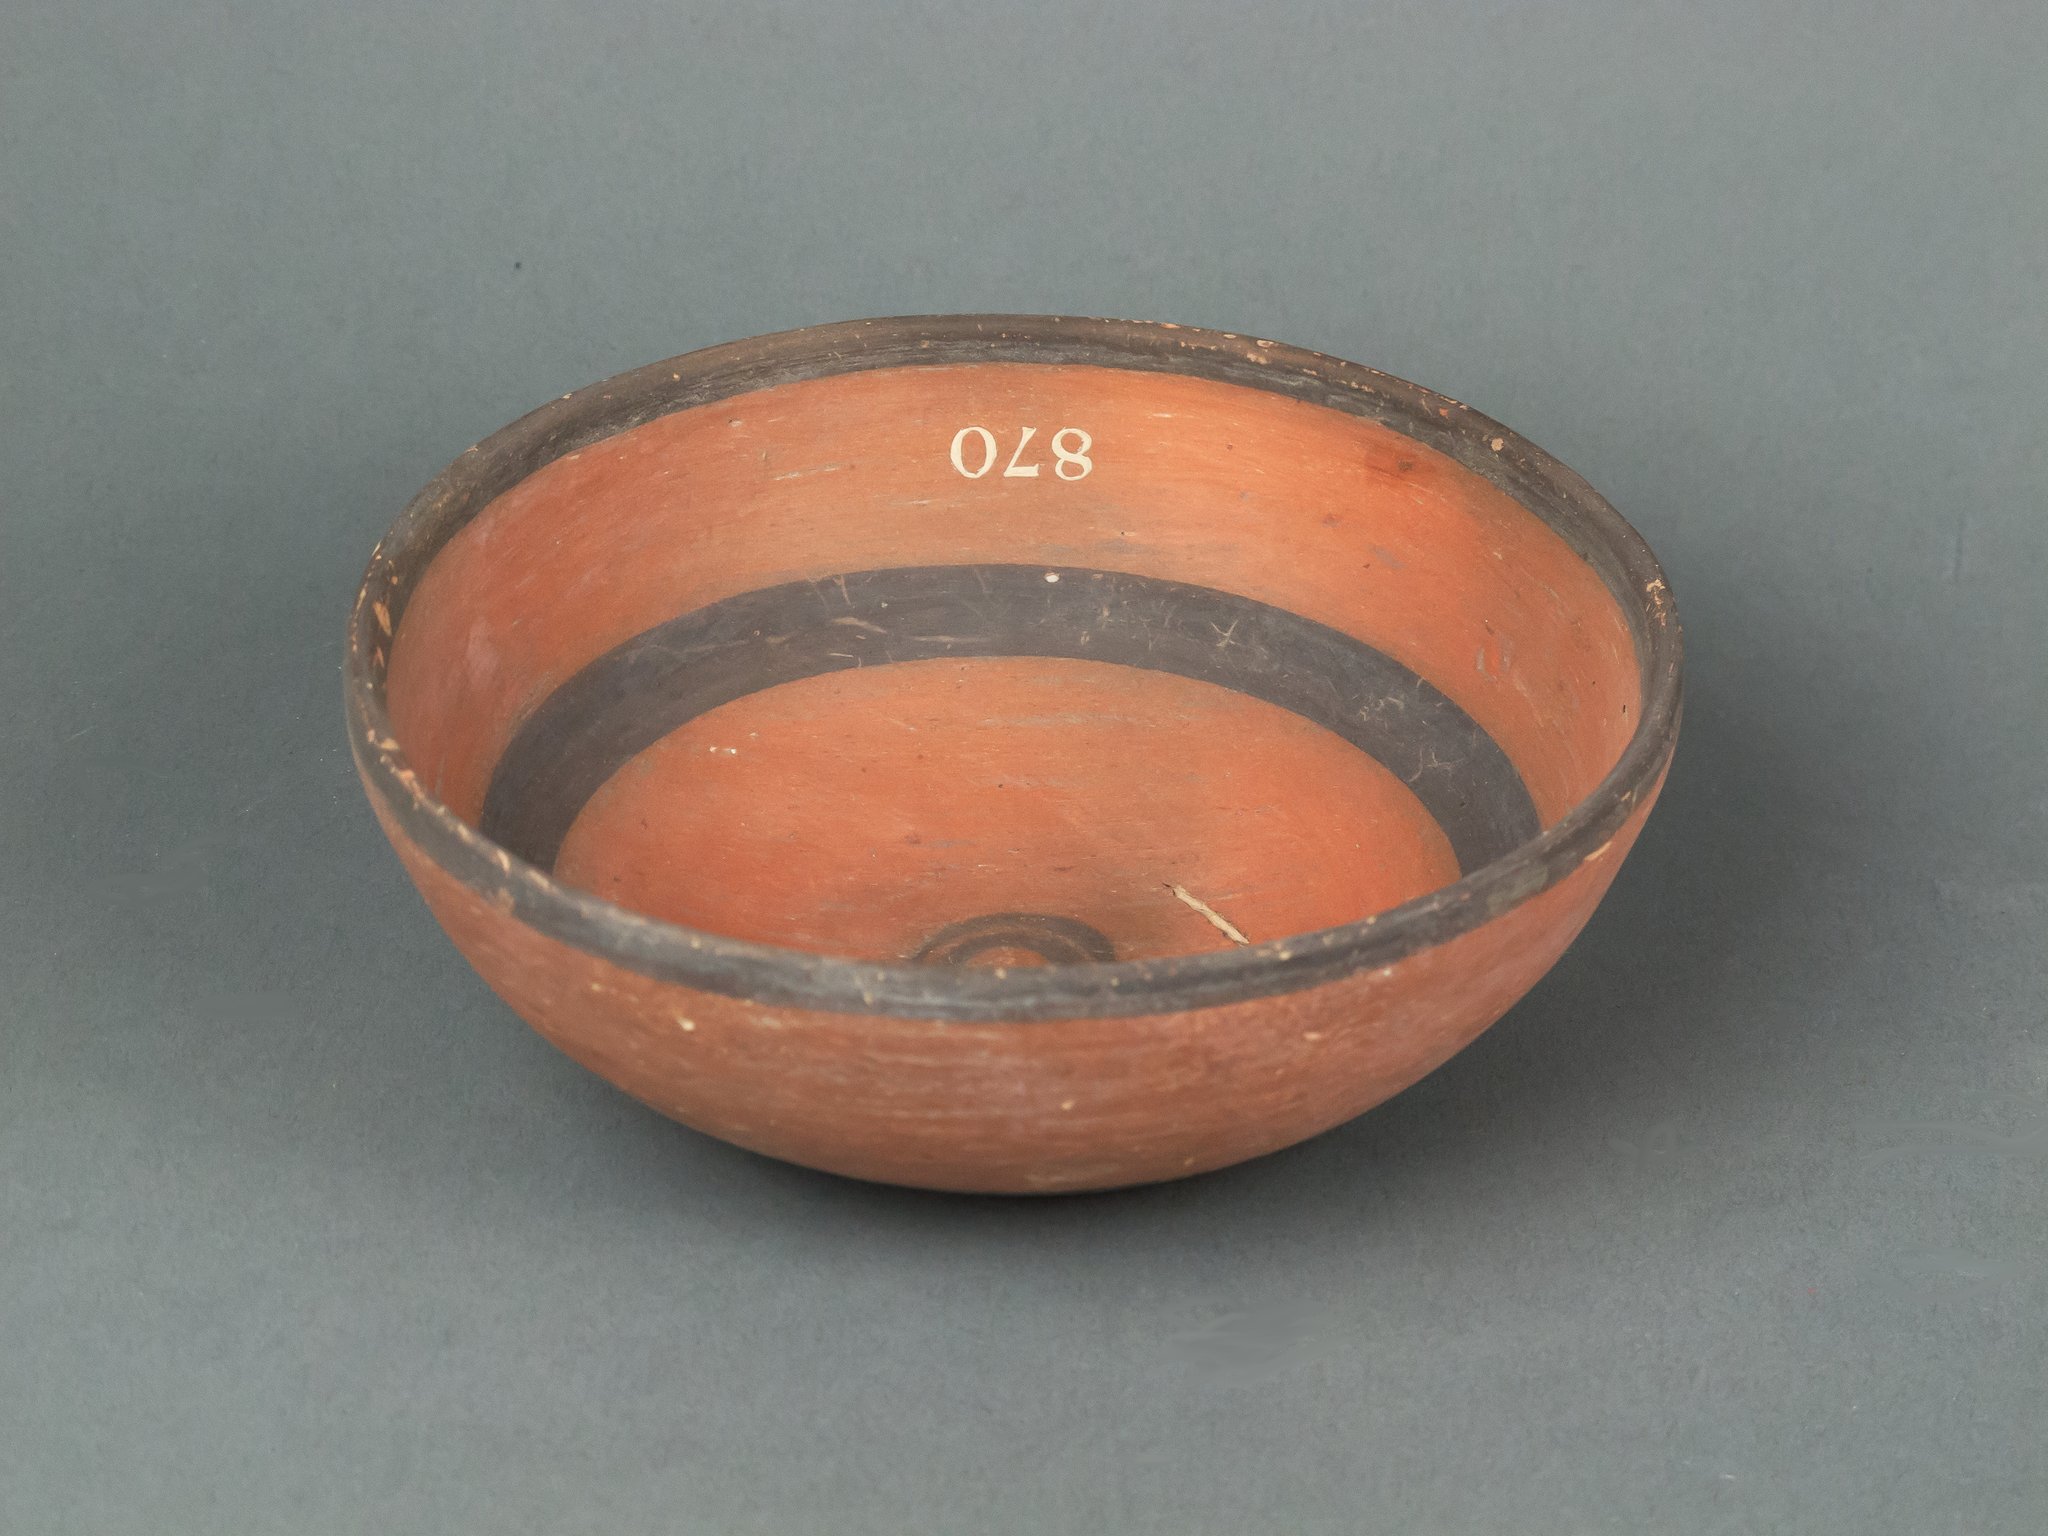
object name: bowl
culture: cypriot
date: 1125-1050 BCE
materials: terracotta